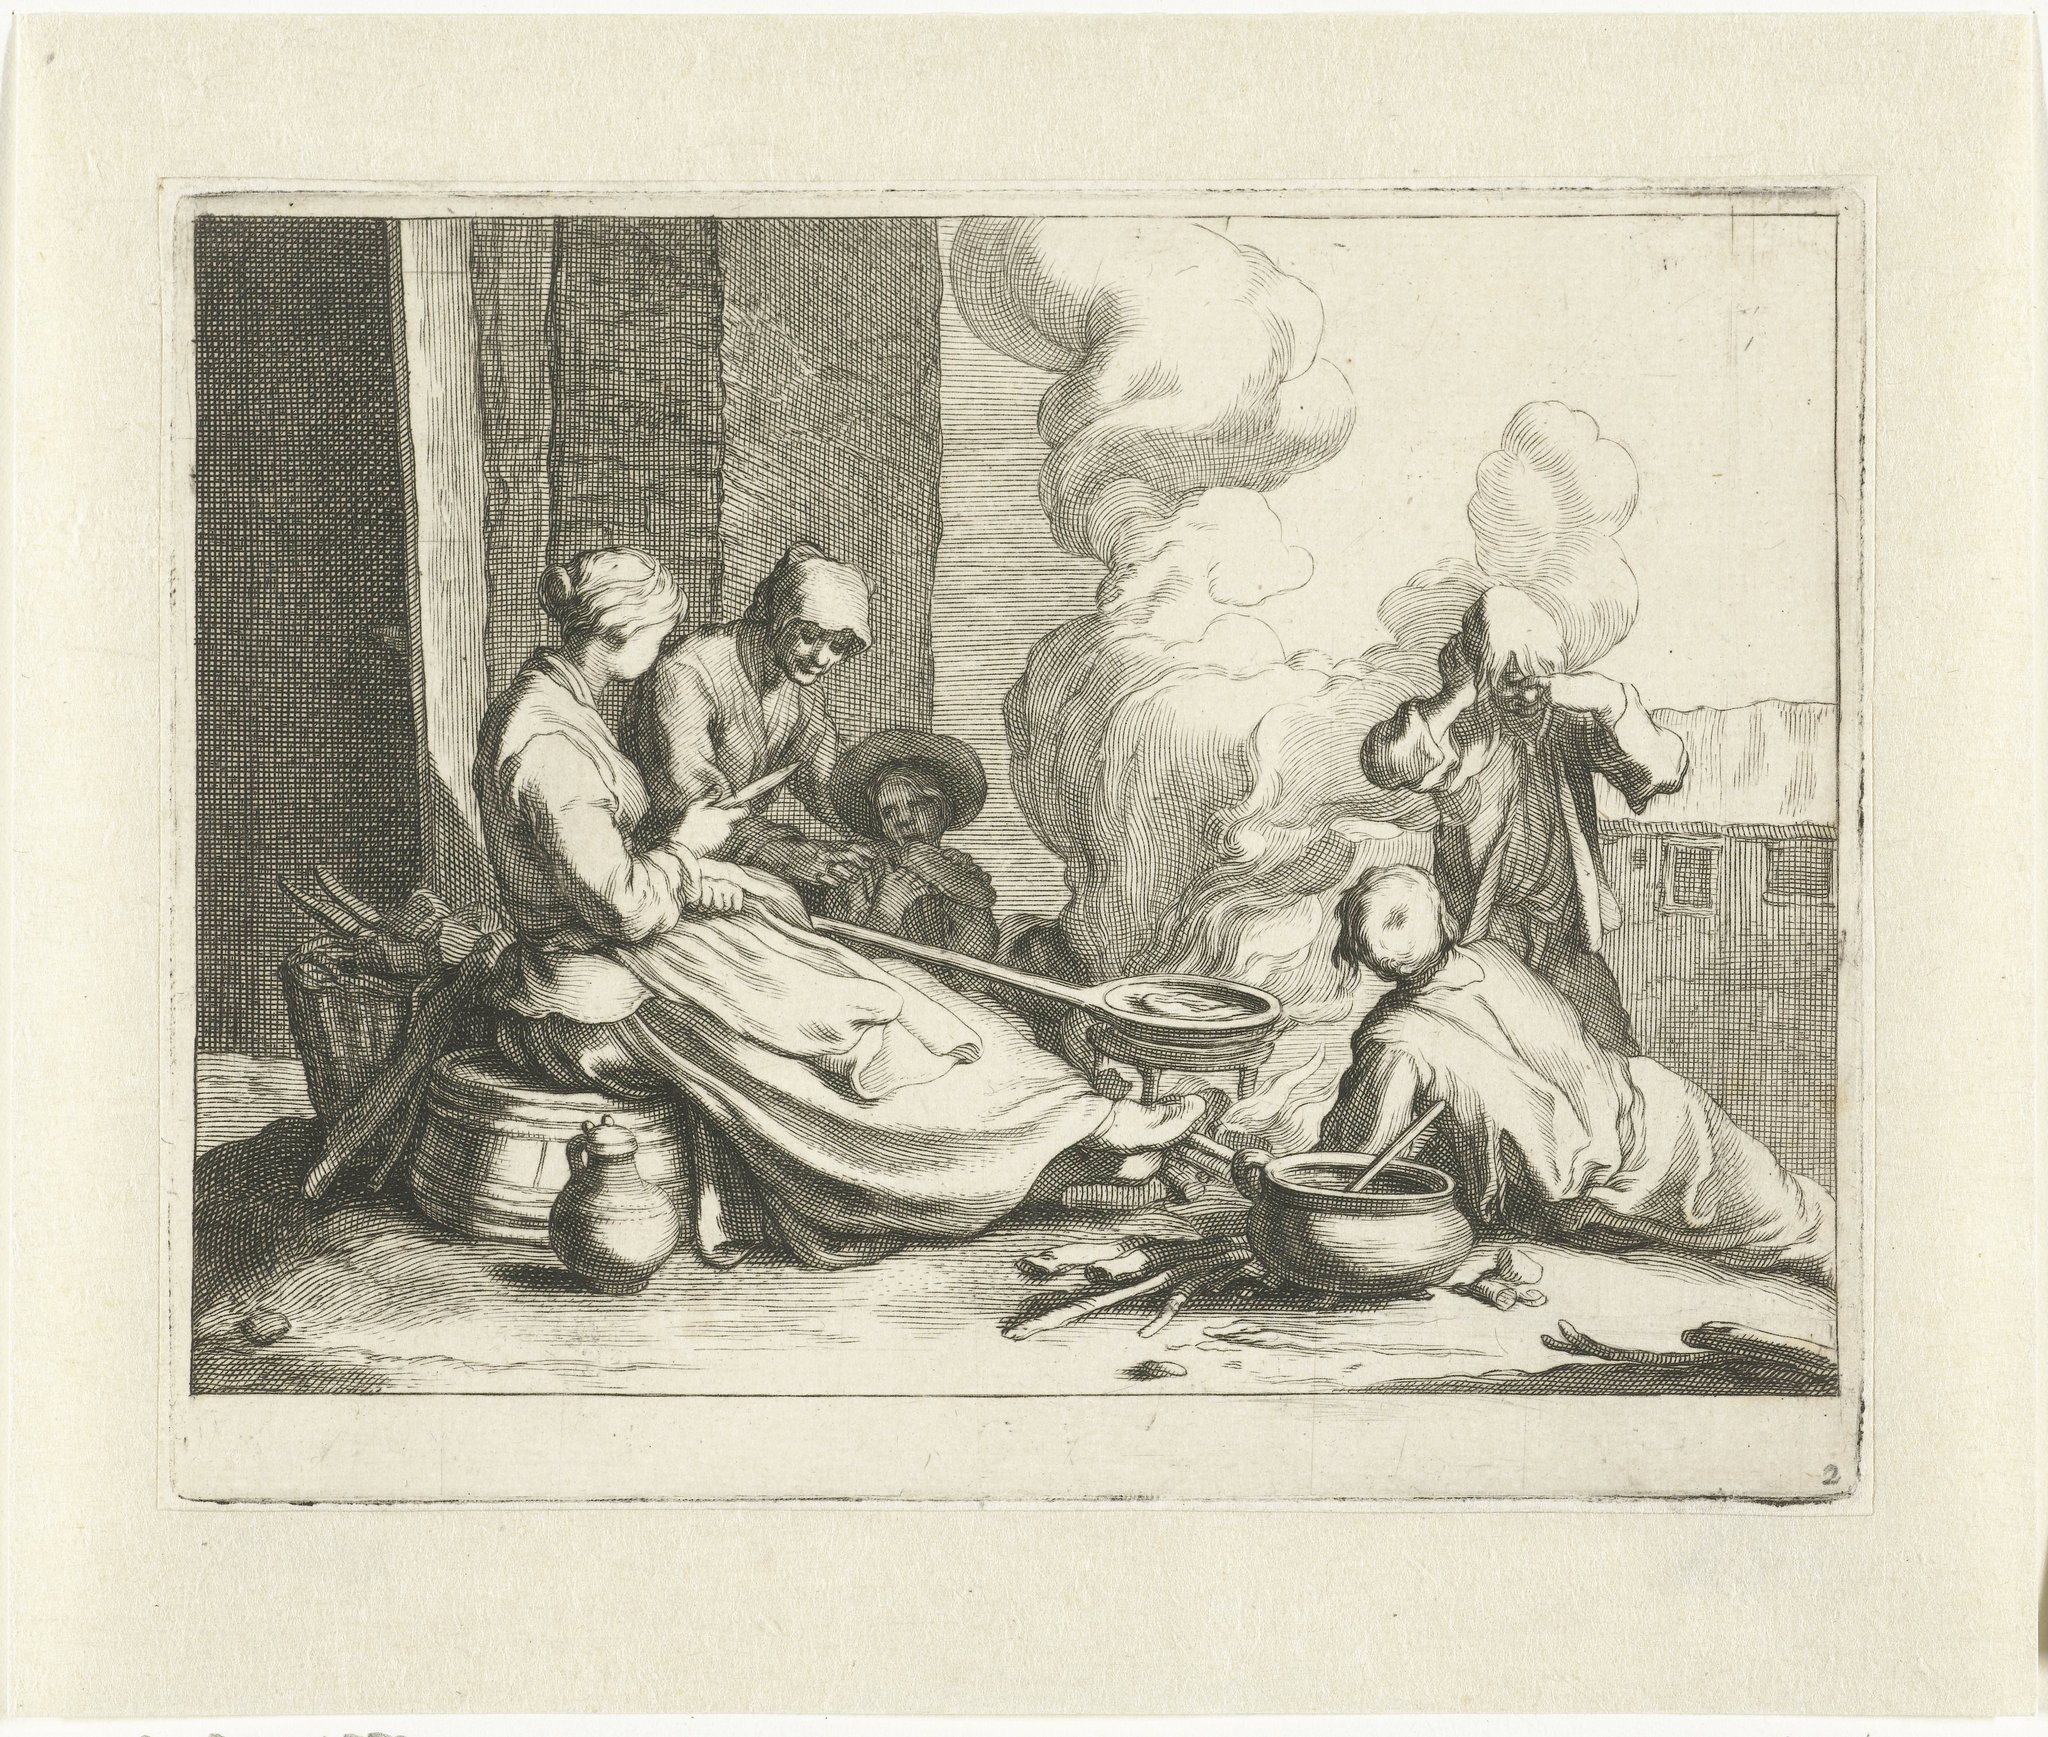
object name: print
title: De maand februari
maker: frederick bloemaert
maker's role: print maker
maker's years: 1614-1669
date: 1635-1670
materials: paper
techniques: engraving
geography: utrecht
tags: pancakes, february and its 'labours', frying - cc - in the open air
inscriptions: collector's mark: Lugt 240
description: Een jonge en een oude vrouwen bakken in de open lucht pannenkoeken in het bijzijn van drie kinderen.